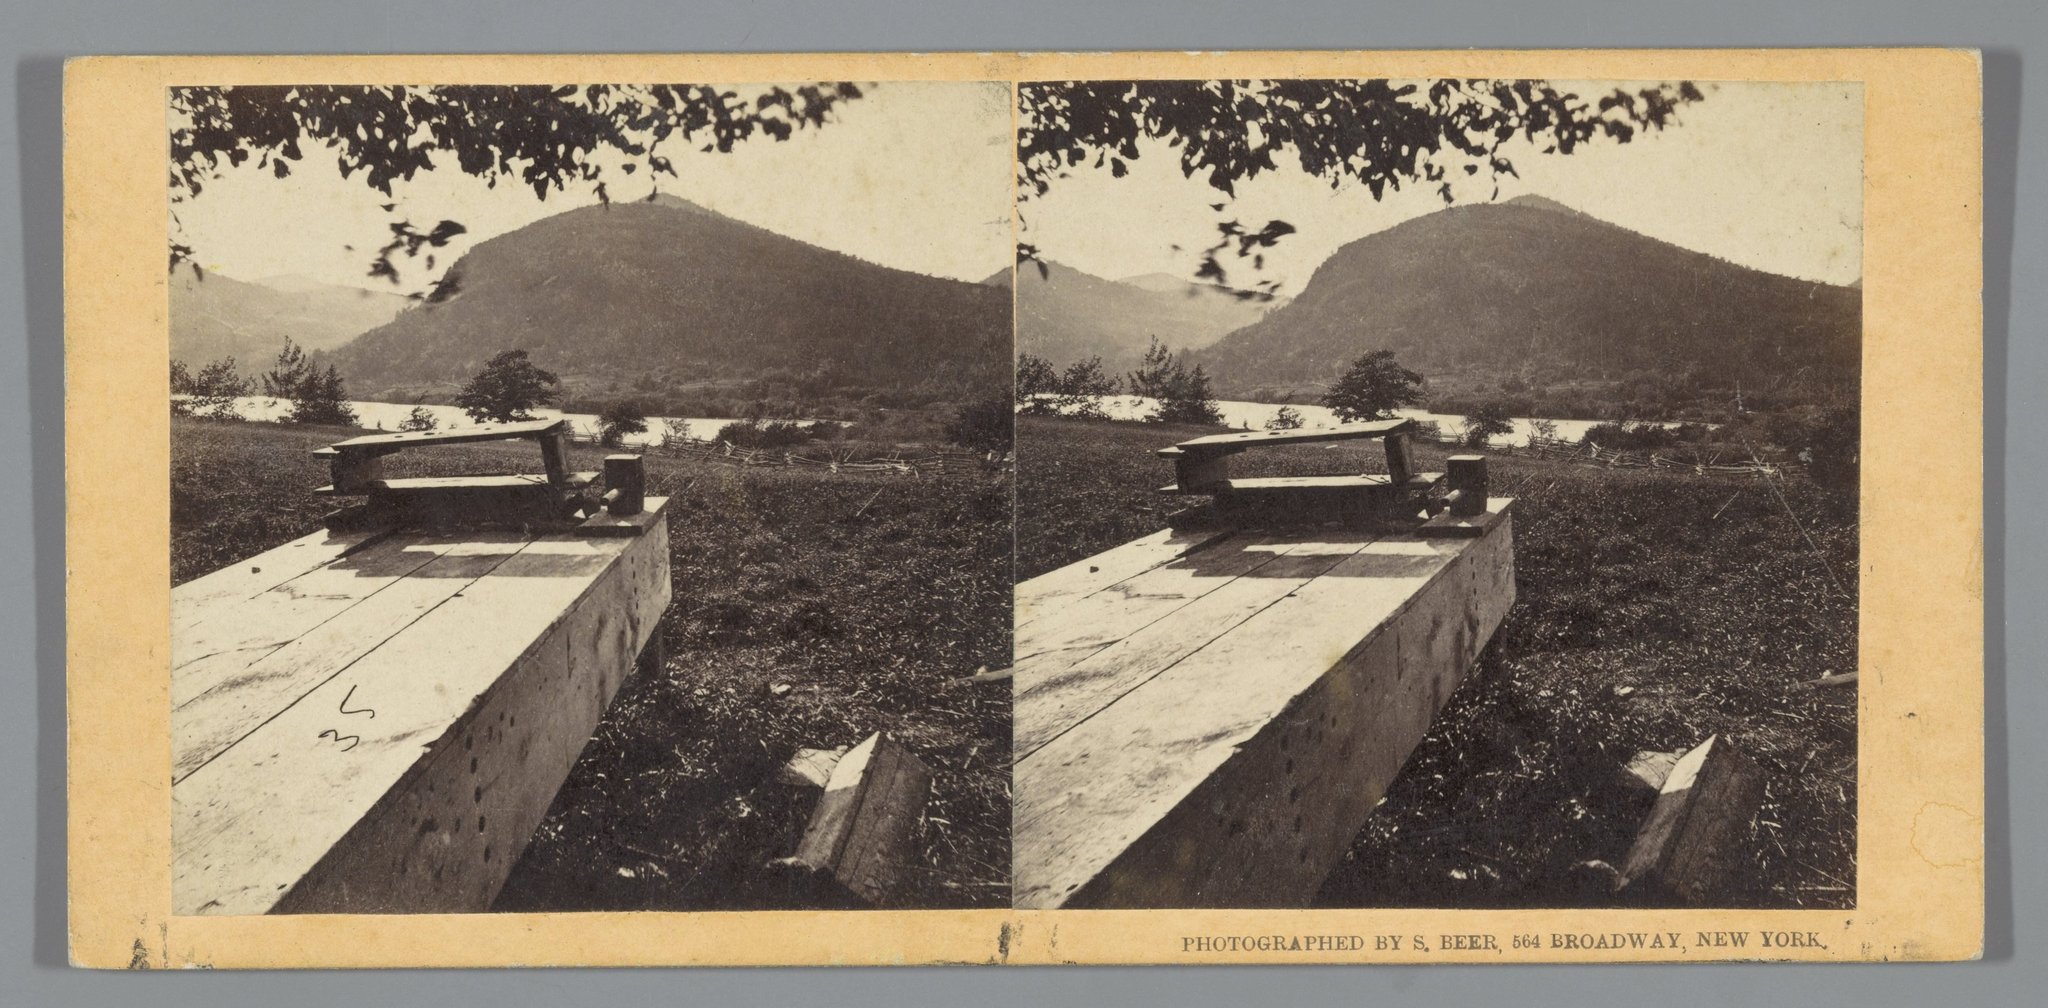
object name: stereograph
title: Lake George, N.Y.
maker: sigismund beer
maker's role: fotograaf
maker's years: 1819-1895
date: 1866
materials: cardboard, paper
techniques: albumen print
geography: new york city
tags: wooden container: barrel, cask, bucket, lake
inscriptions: number: ‘35’, : ‘Caldwell. Fort William (...) Beer & Co.’, address: ‘564 Broadway, New York’